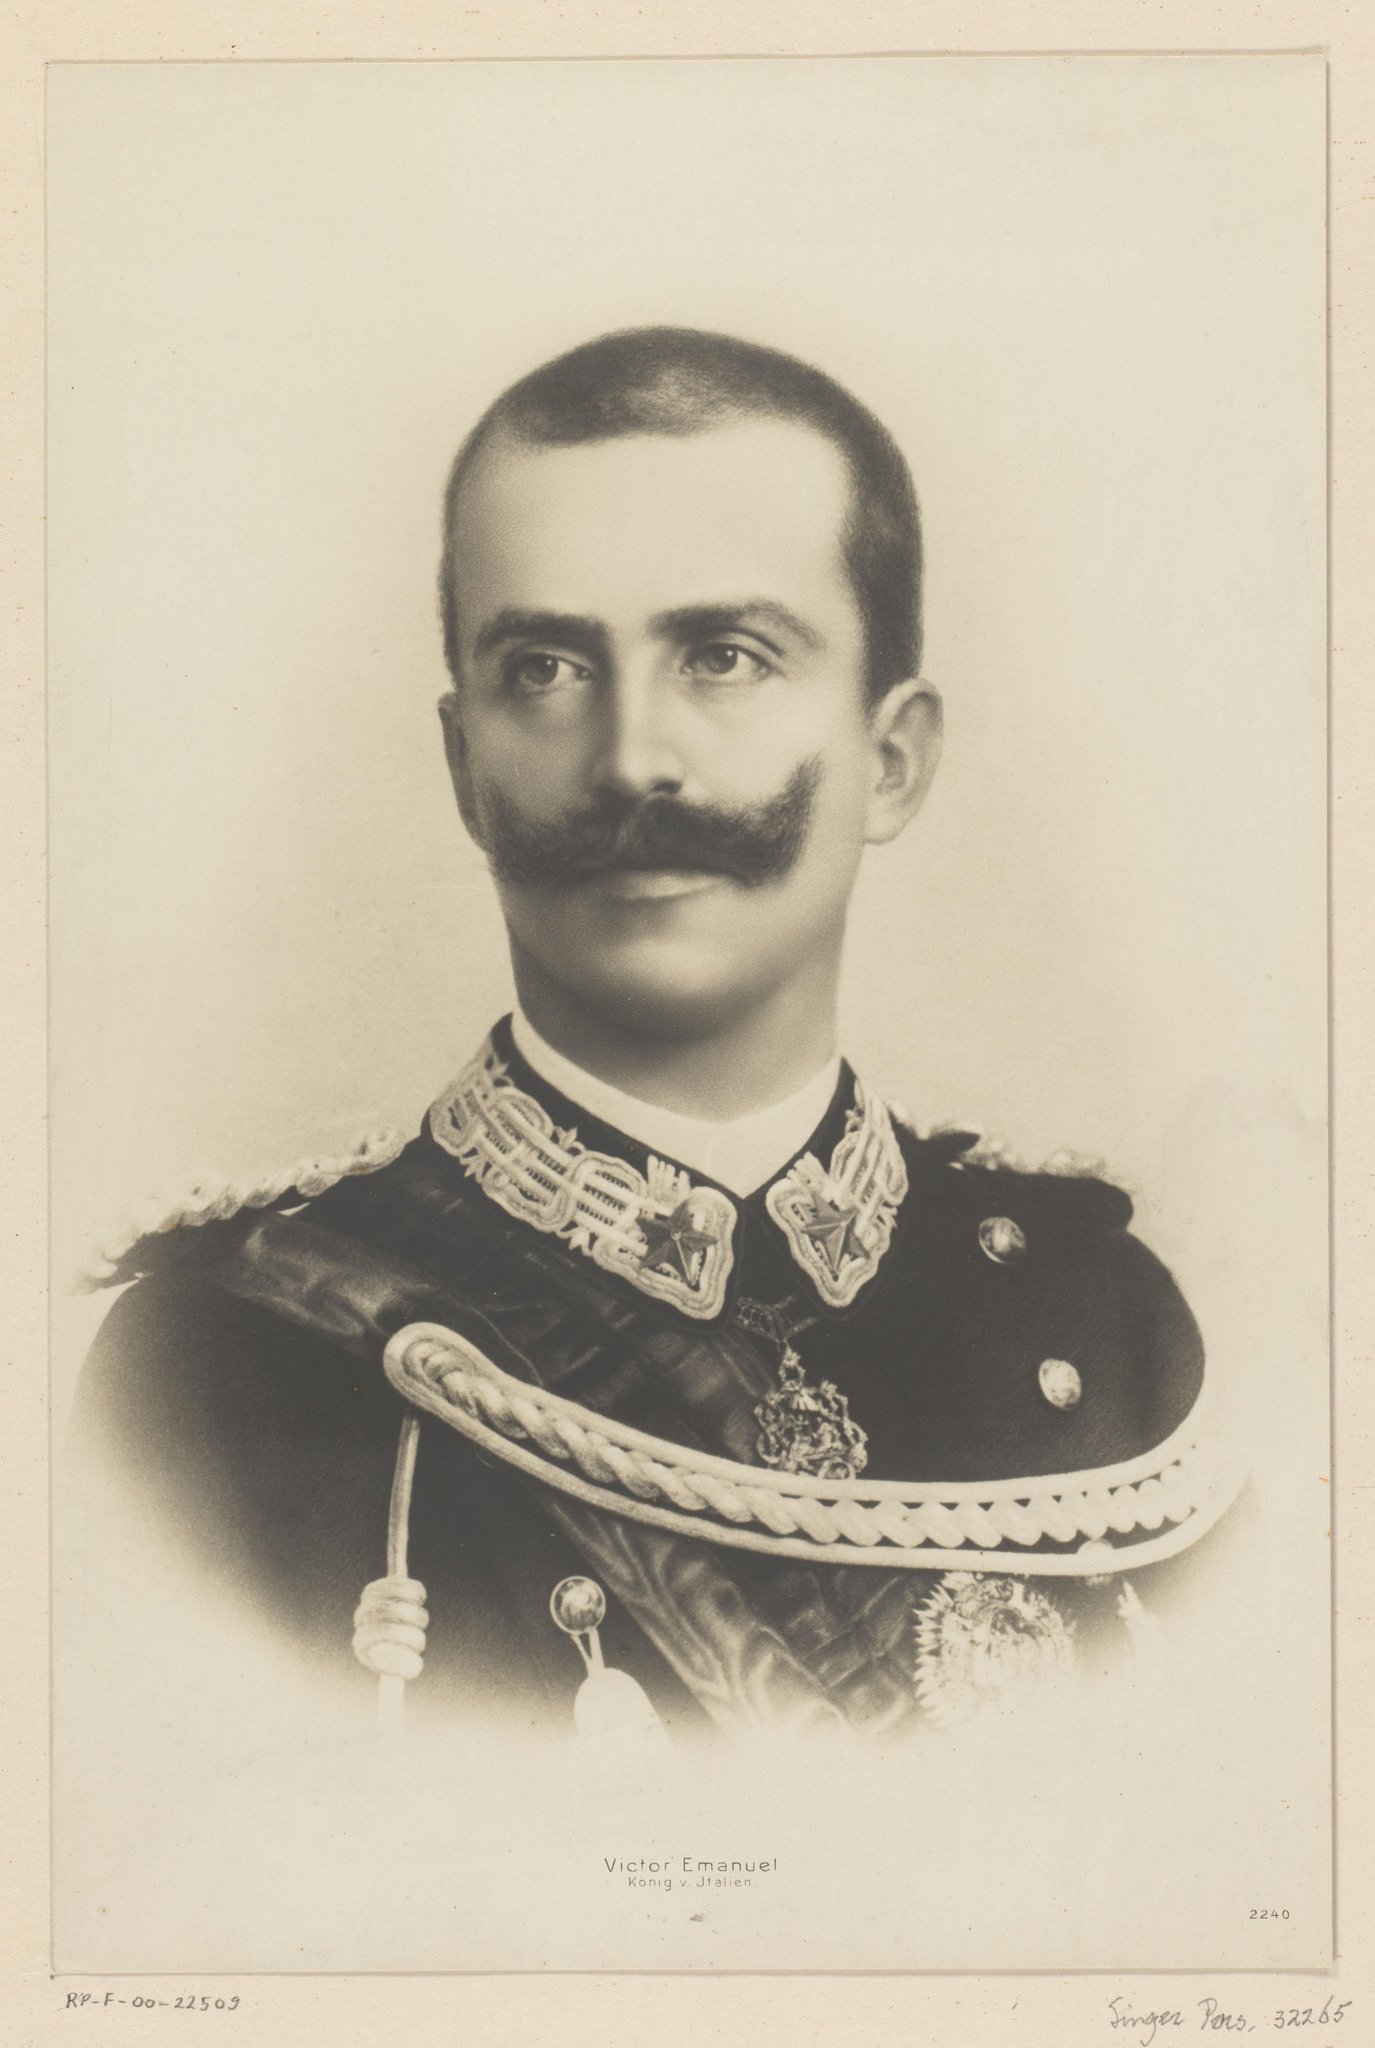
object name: photograph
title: Victor Emanuel, König v. Italien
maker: Anonymous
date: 1900-1920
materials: paper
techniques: gelatin silver print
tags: historical persons, king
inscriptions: number: ‘2240’